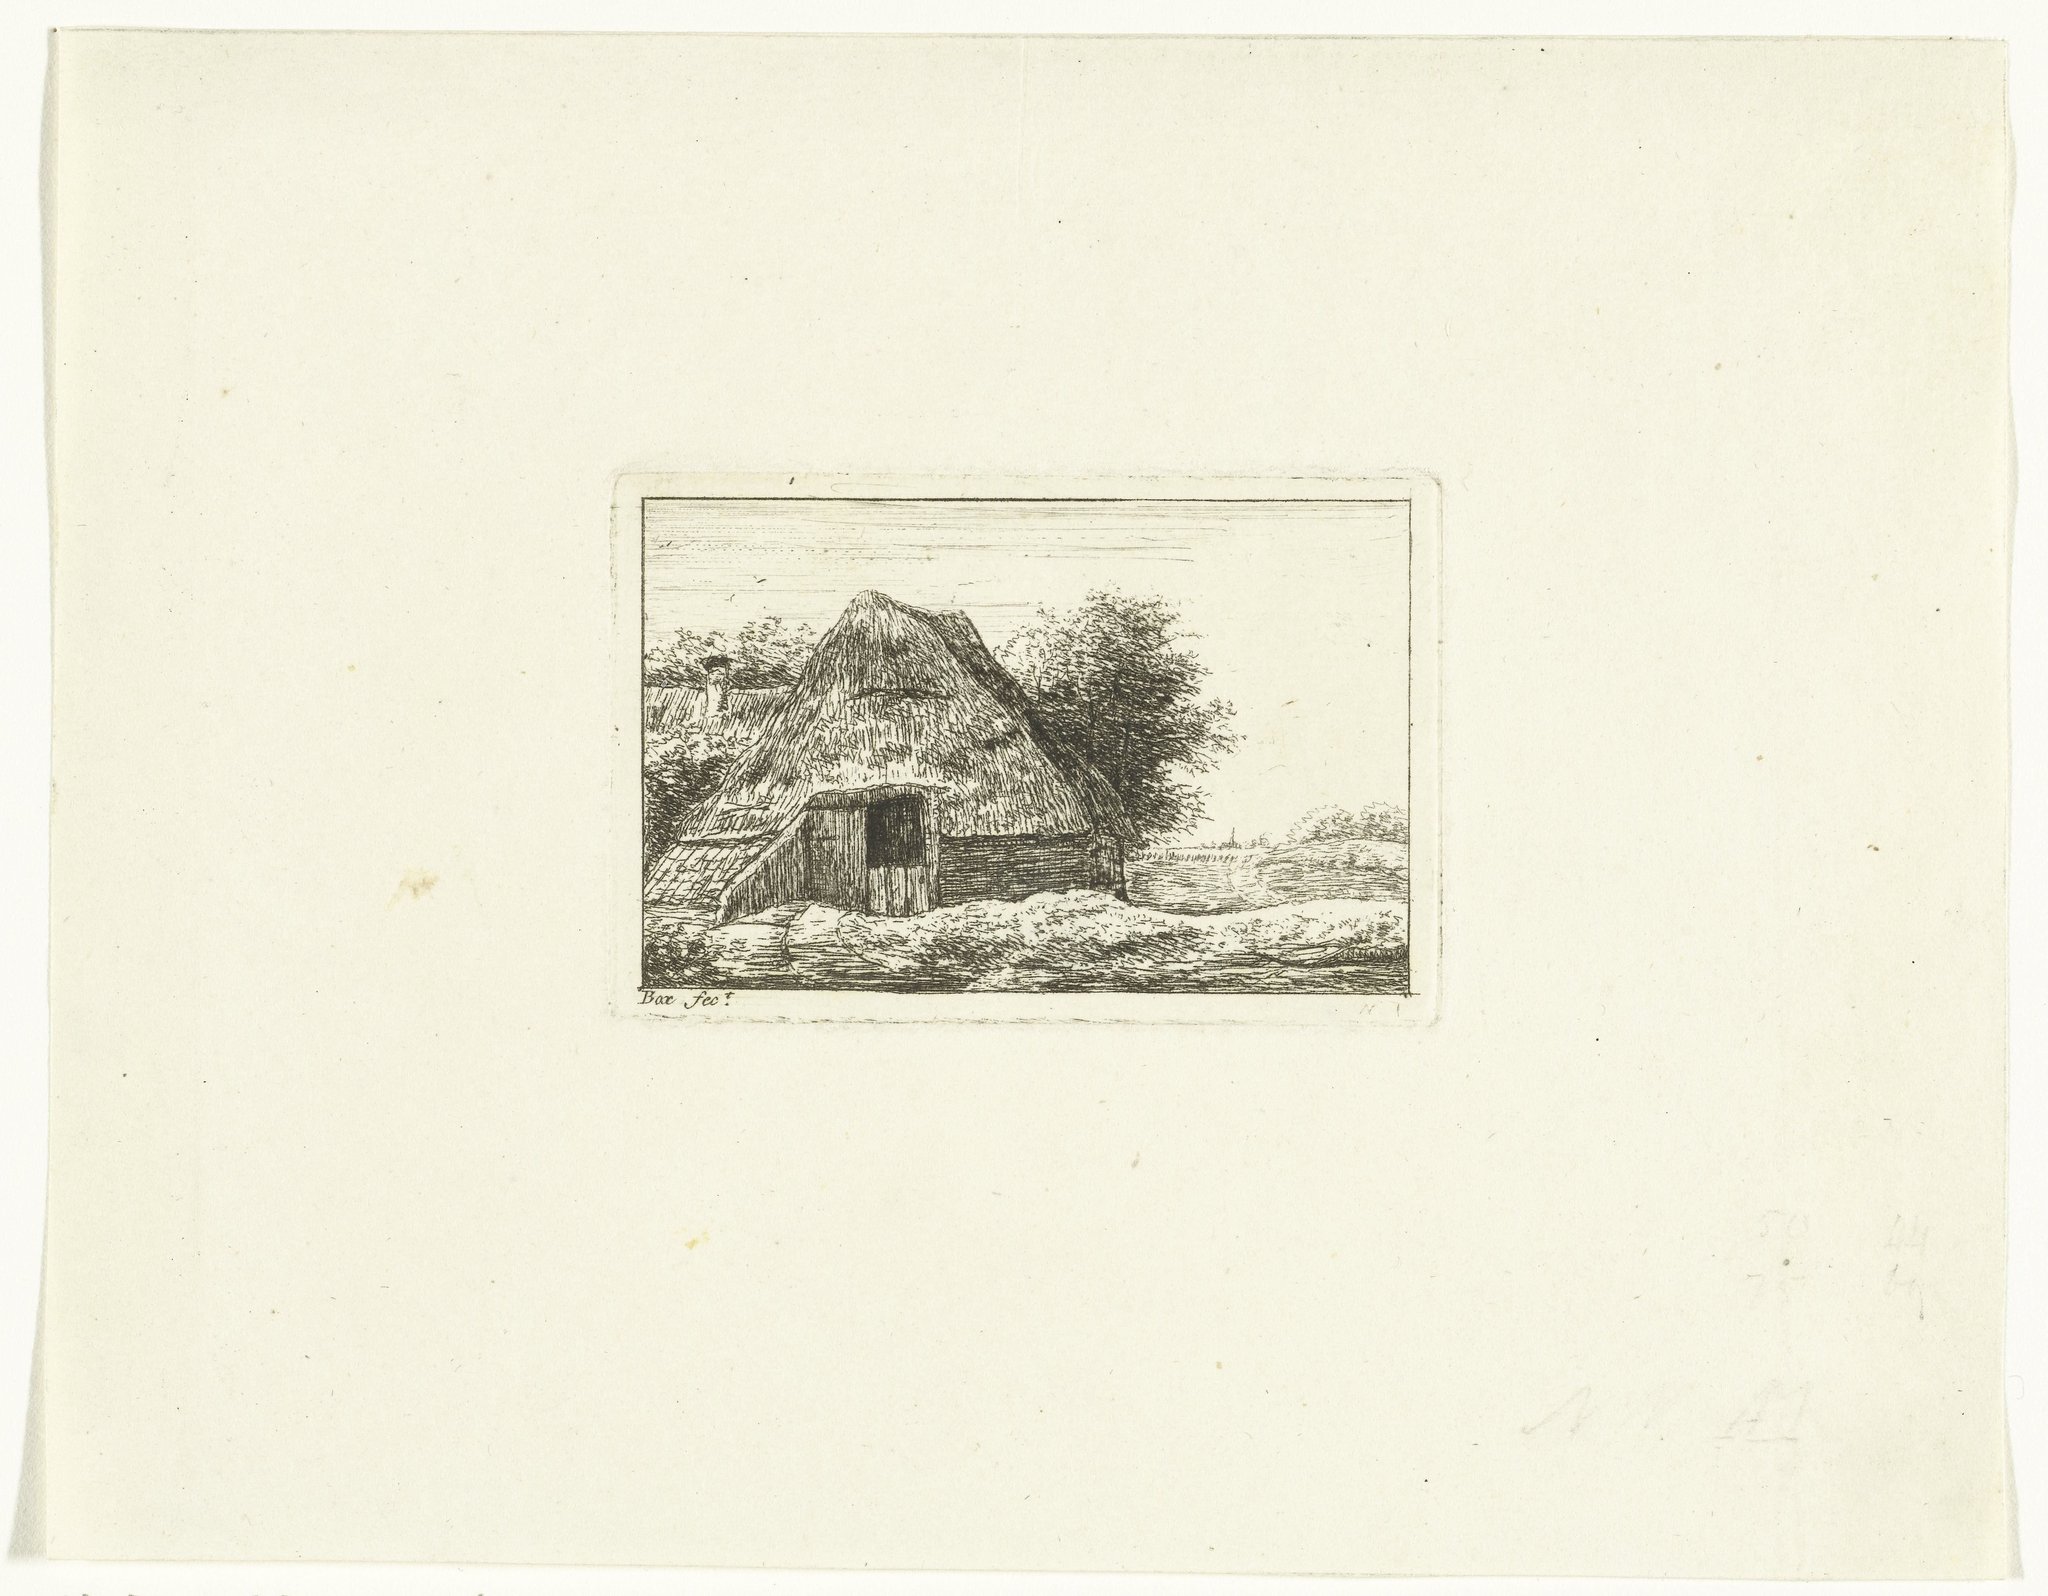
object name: print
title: Boerenwoning, bovendeel van de deur geopend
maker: hans willem box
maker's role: print maker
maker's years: 1790-1841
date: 1805-1841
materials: paper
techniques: etching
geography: netherlands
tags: farm (building)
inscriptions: collector's mark: Lugt 2228